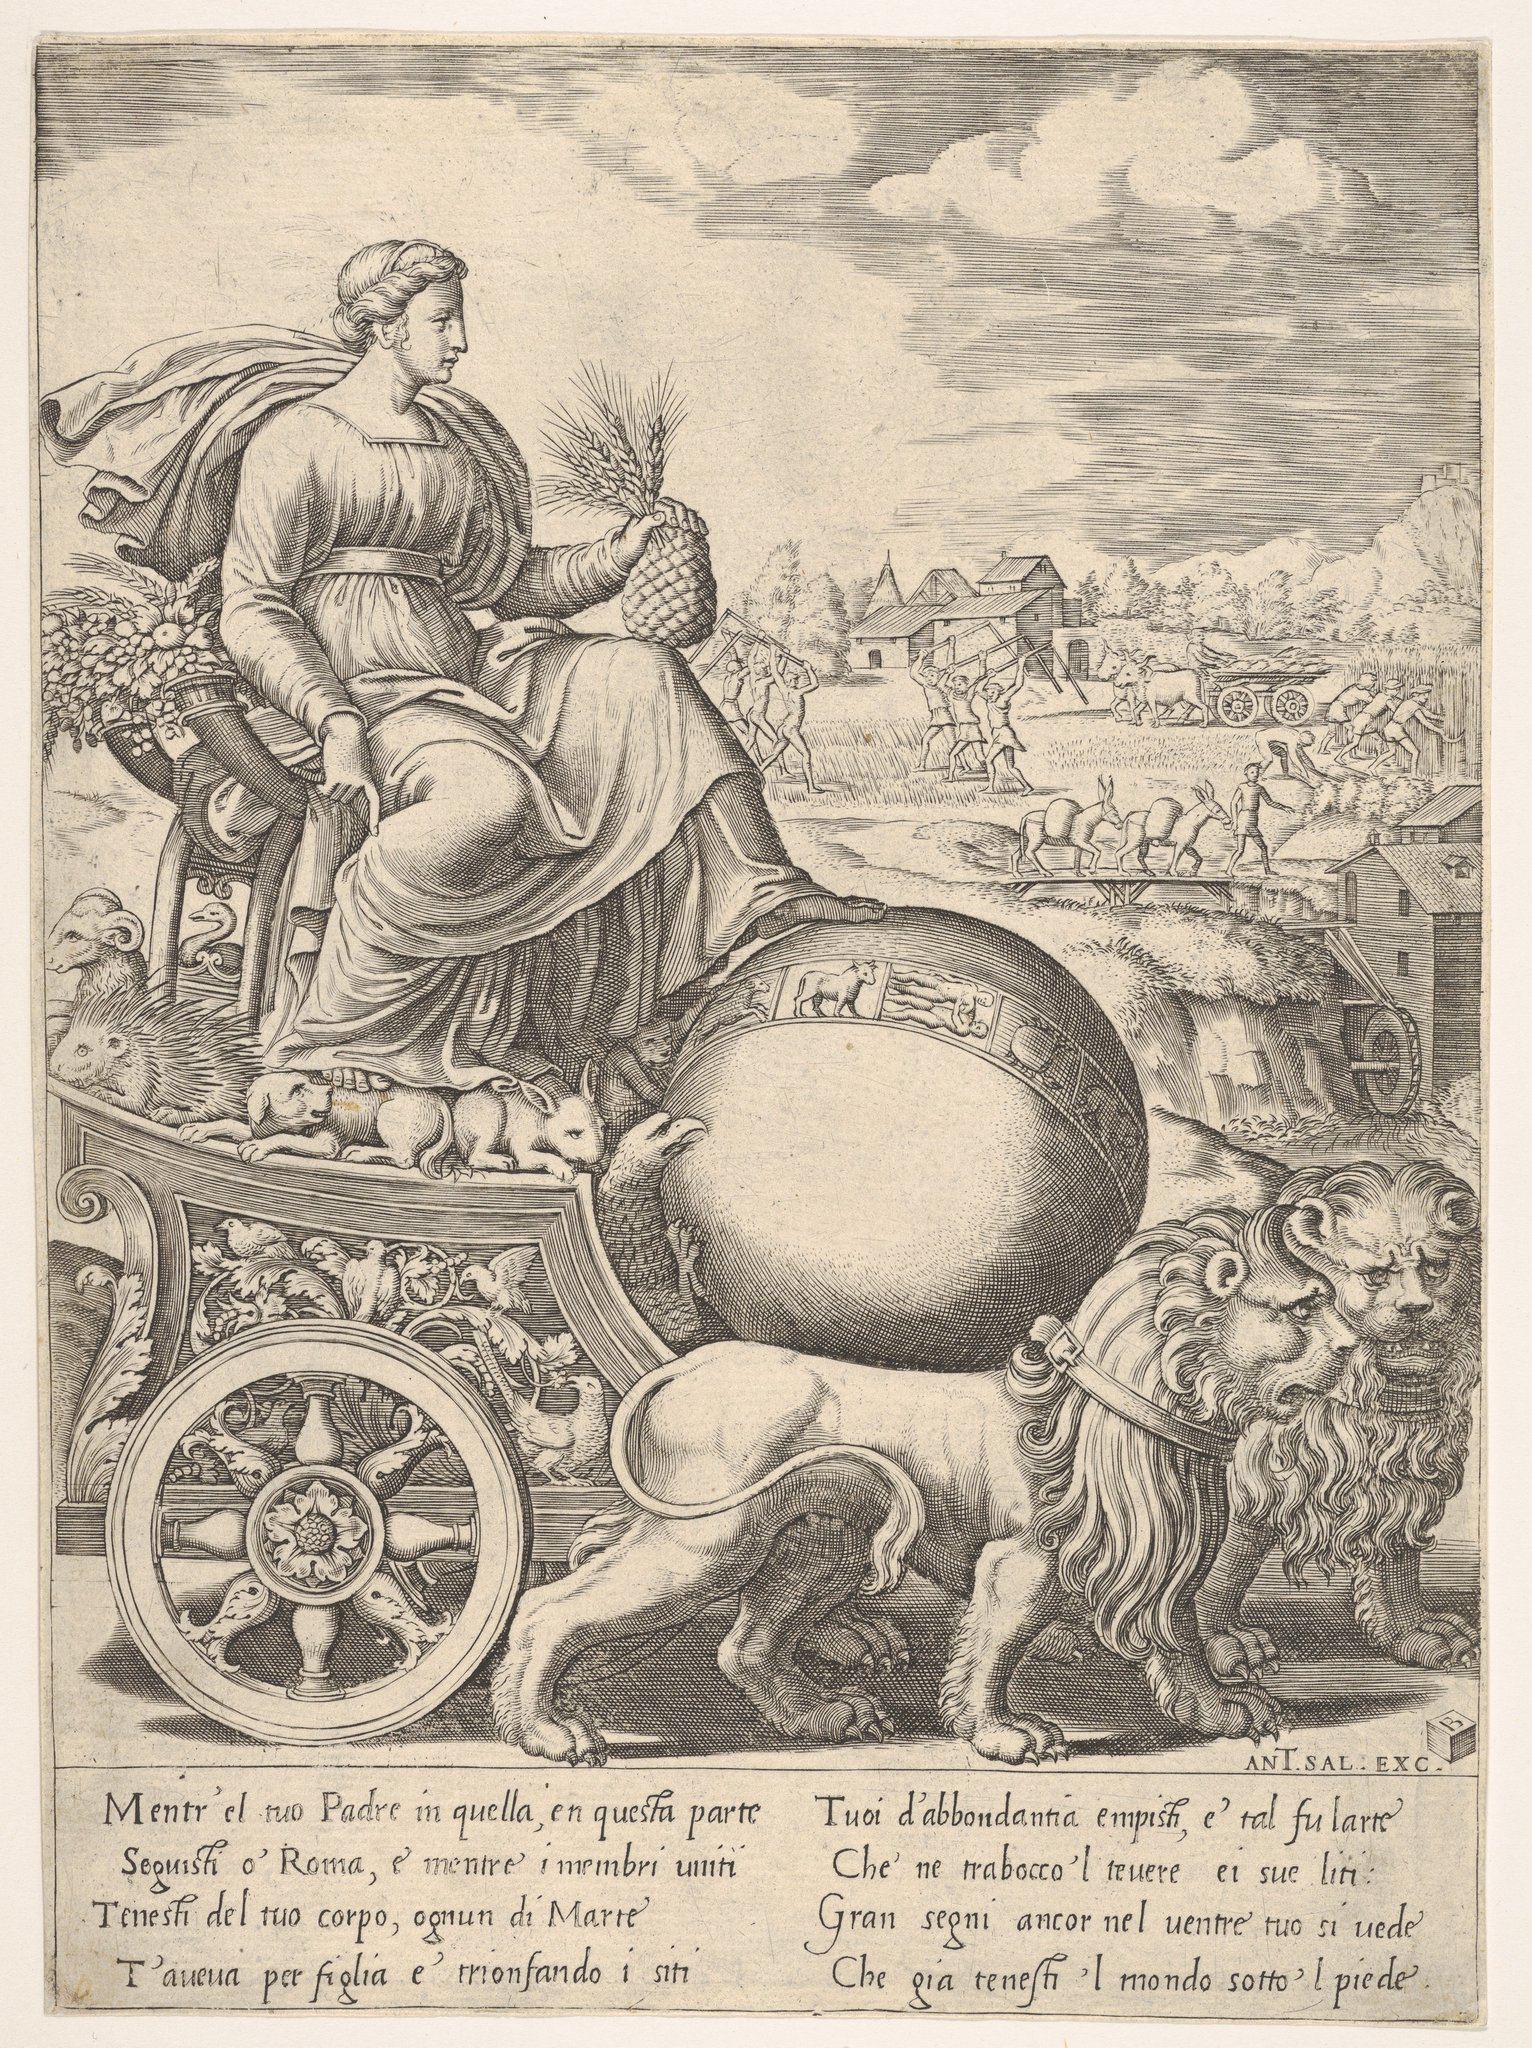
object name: print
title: Cybele in her chariot drawn by two lions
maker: master of the die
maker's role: artist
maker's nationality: italian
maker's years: 1525-1560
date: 1530-1560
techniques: engraving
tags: lions,goddess,chariots